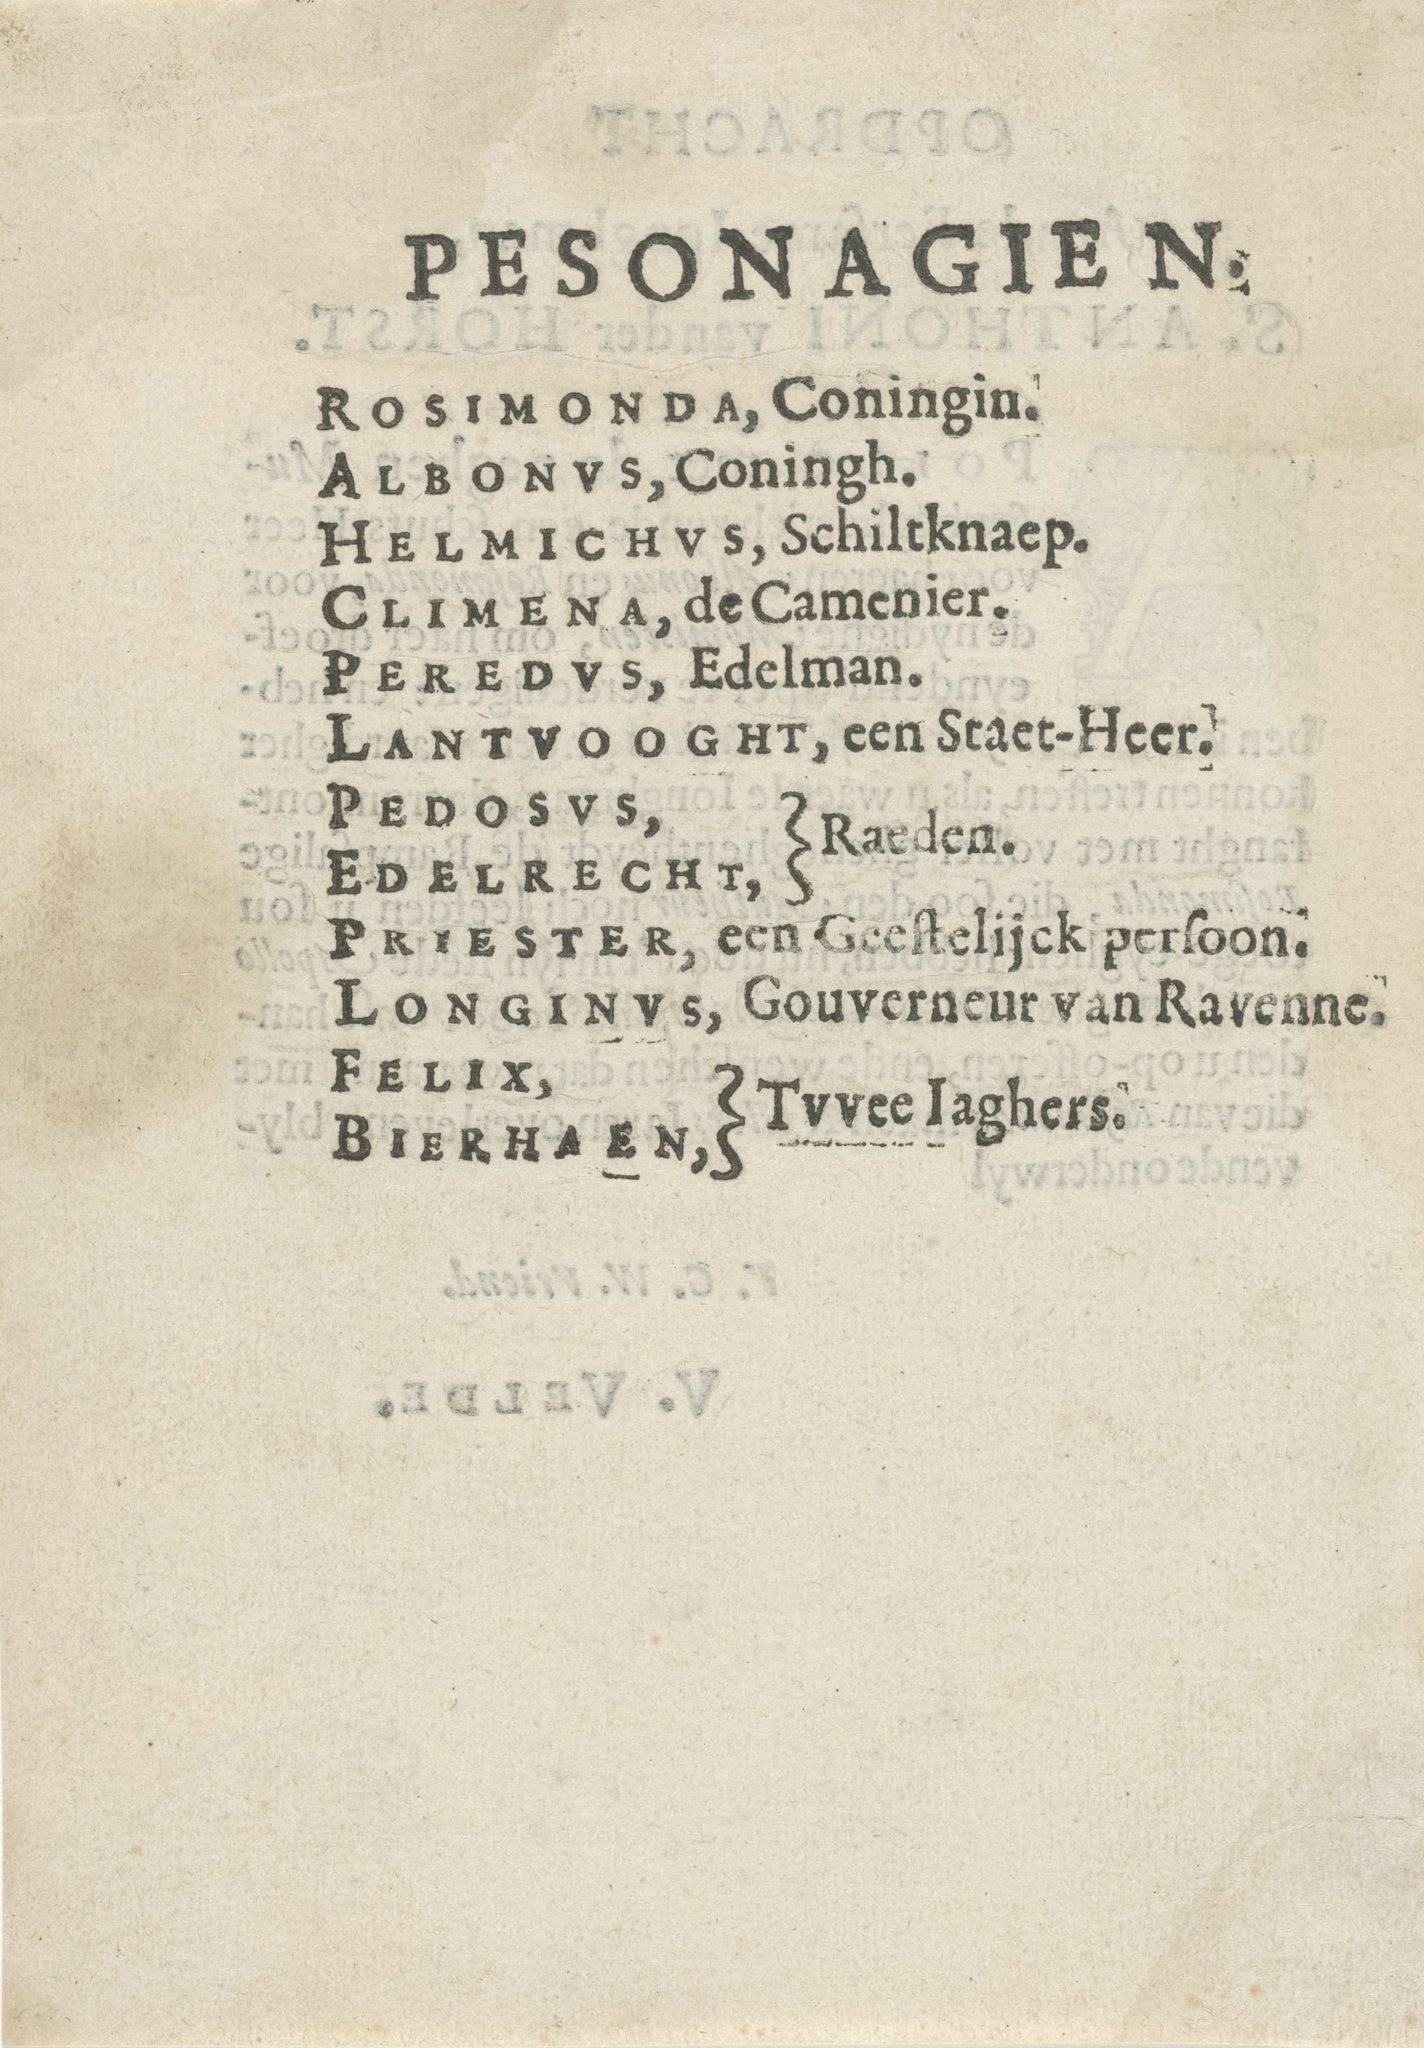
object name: text sheet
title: Tekstblad uit J. Struys, Albonus en Rosimonda treur-spel, 1631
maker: cornelis willemsz blaeu-laken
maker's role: publisher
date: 1612-1655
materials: paper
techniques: letterpress printing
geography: amsterdam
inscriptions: collector's mark: Lugt 2228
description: Tekstblad met de lijst van personages voor het treurspel Albonus en Rosimonda. Op het verso de opdracht van het boek.